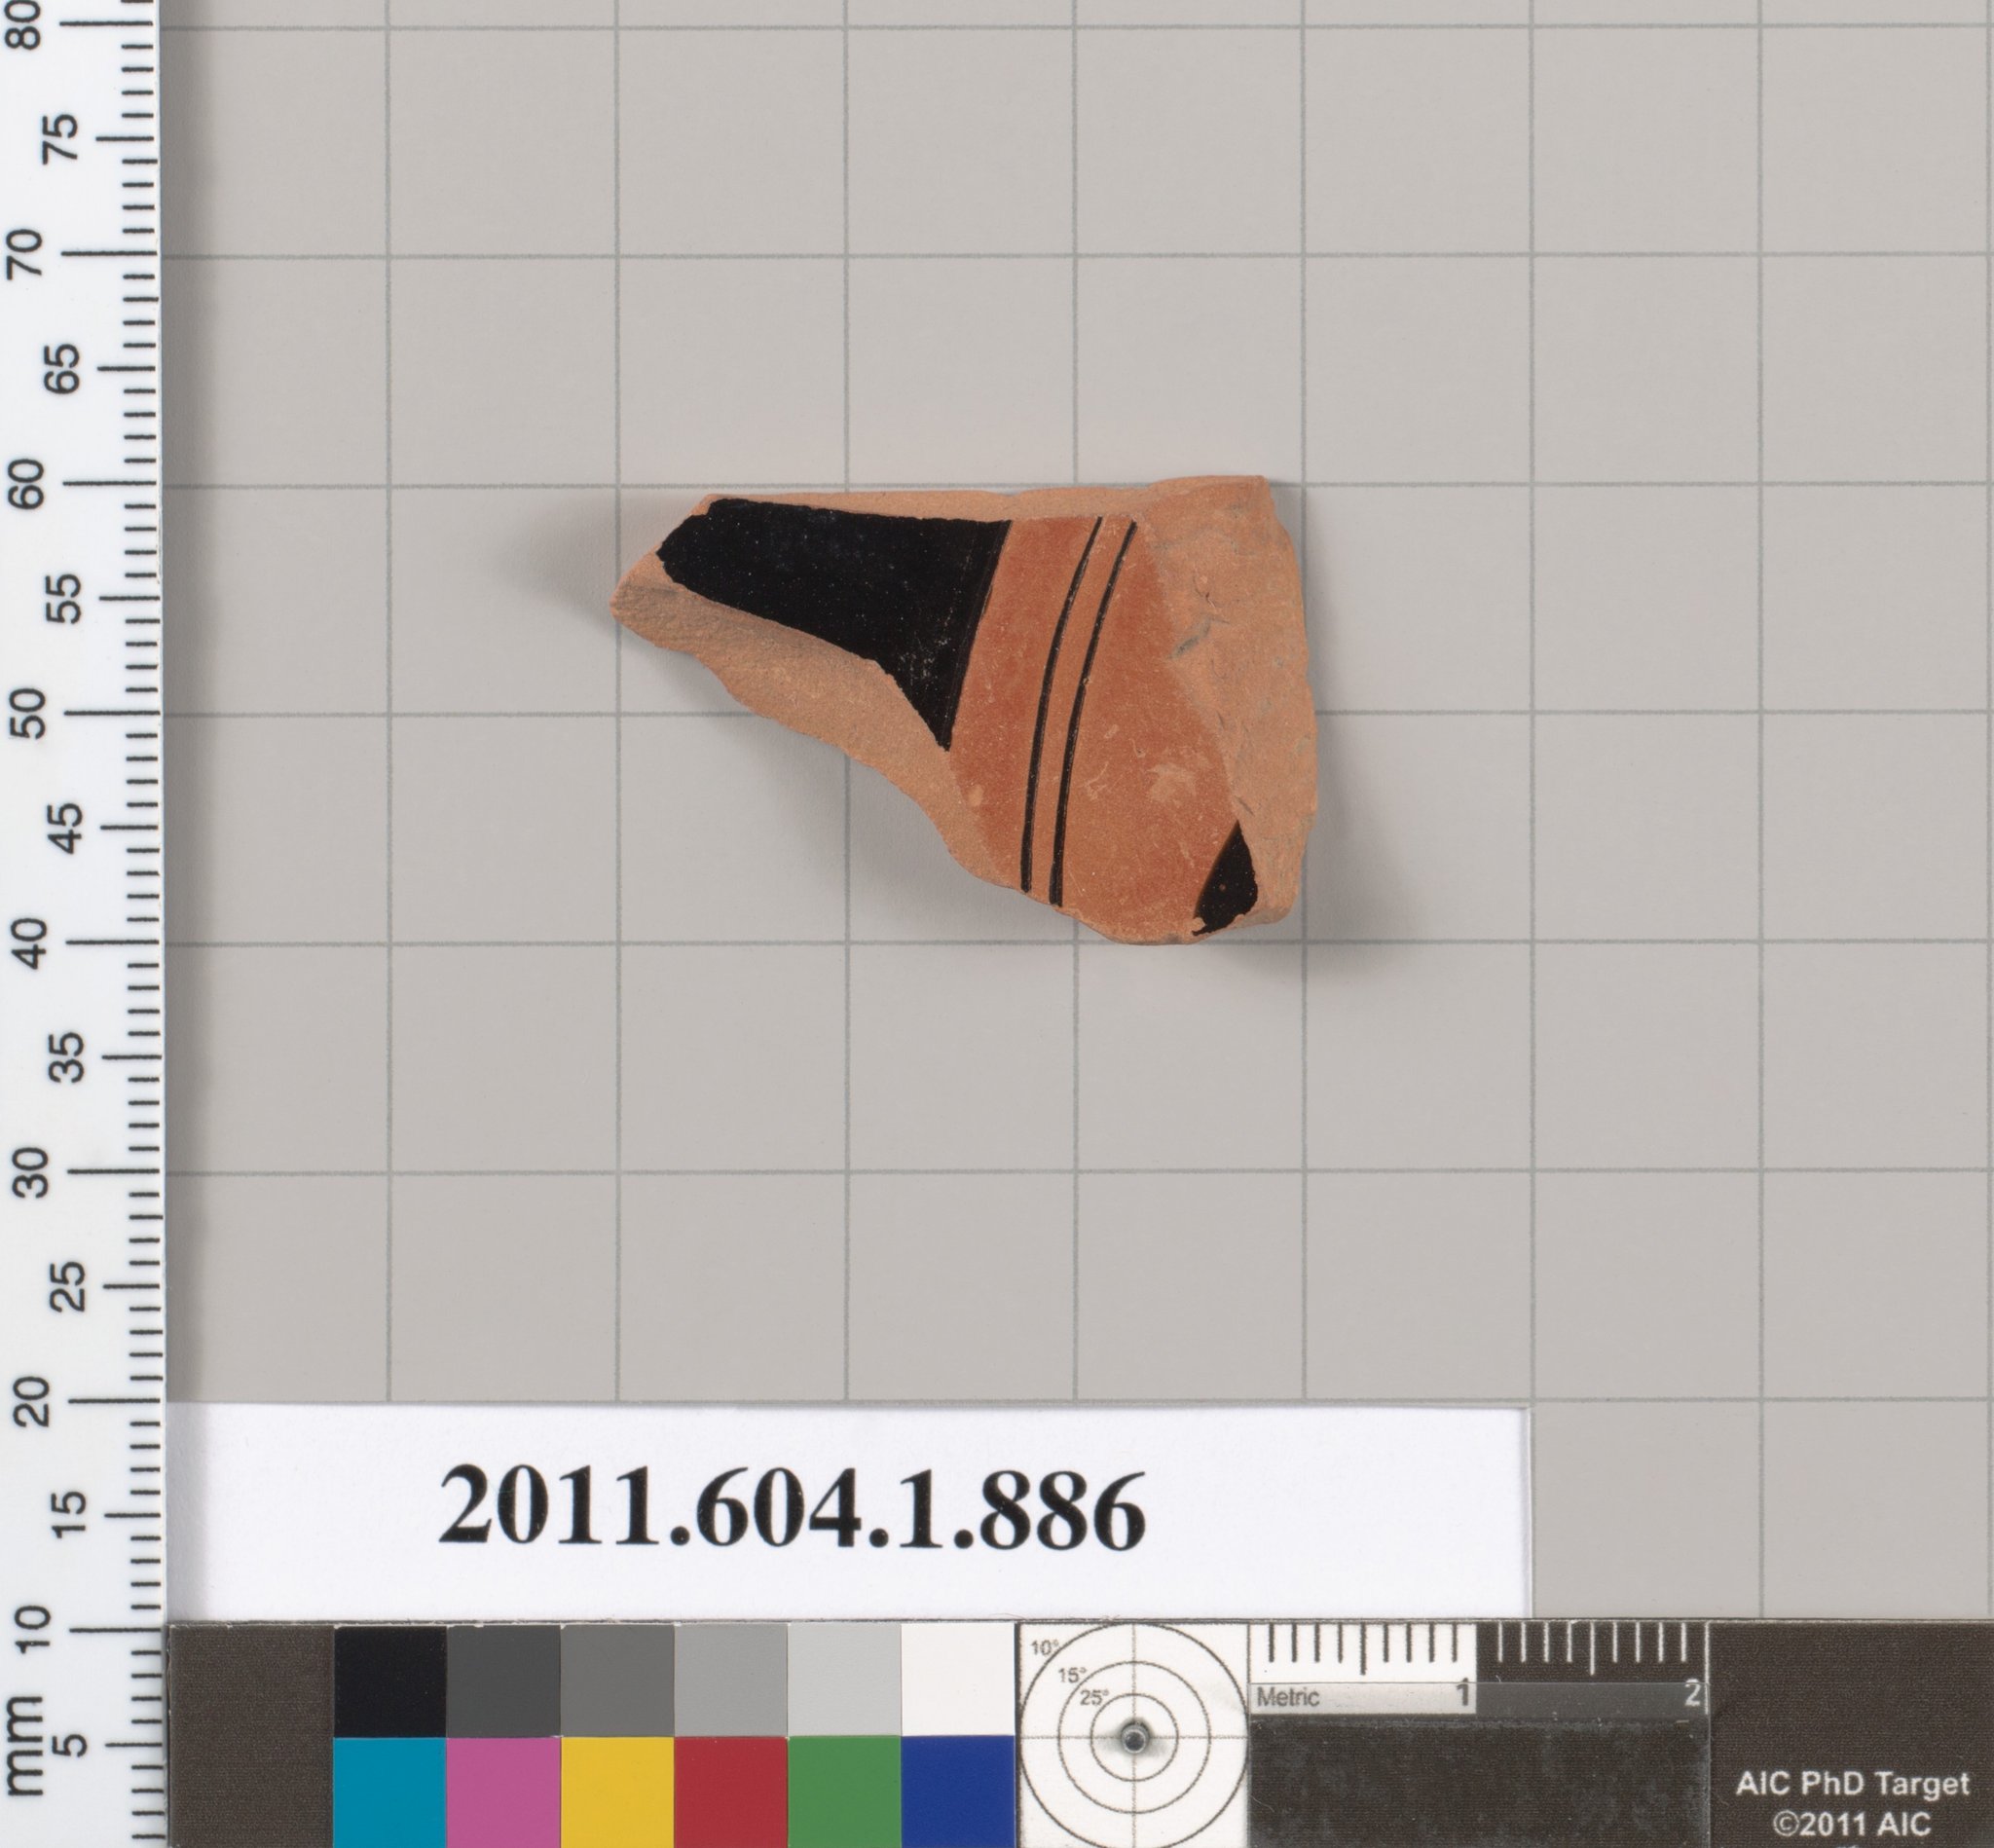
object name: kylix fragment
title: Terracotta fragment of a kylix (drinking cup)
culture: greek, attic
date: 490-480 BCE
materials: terracotta